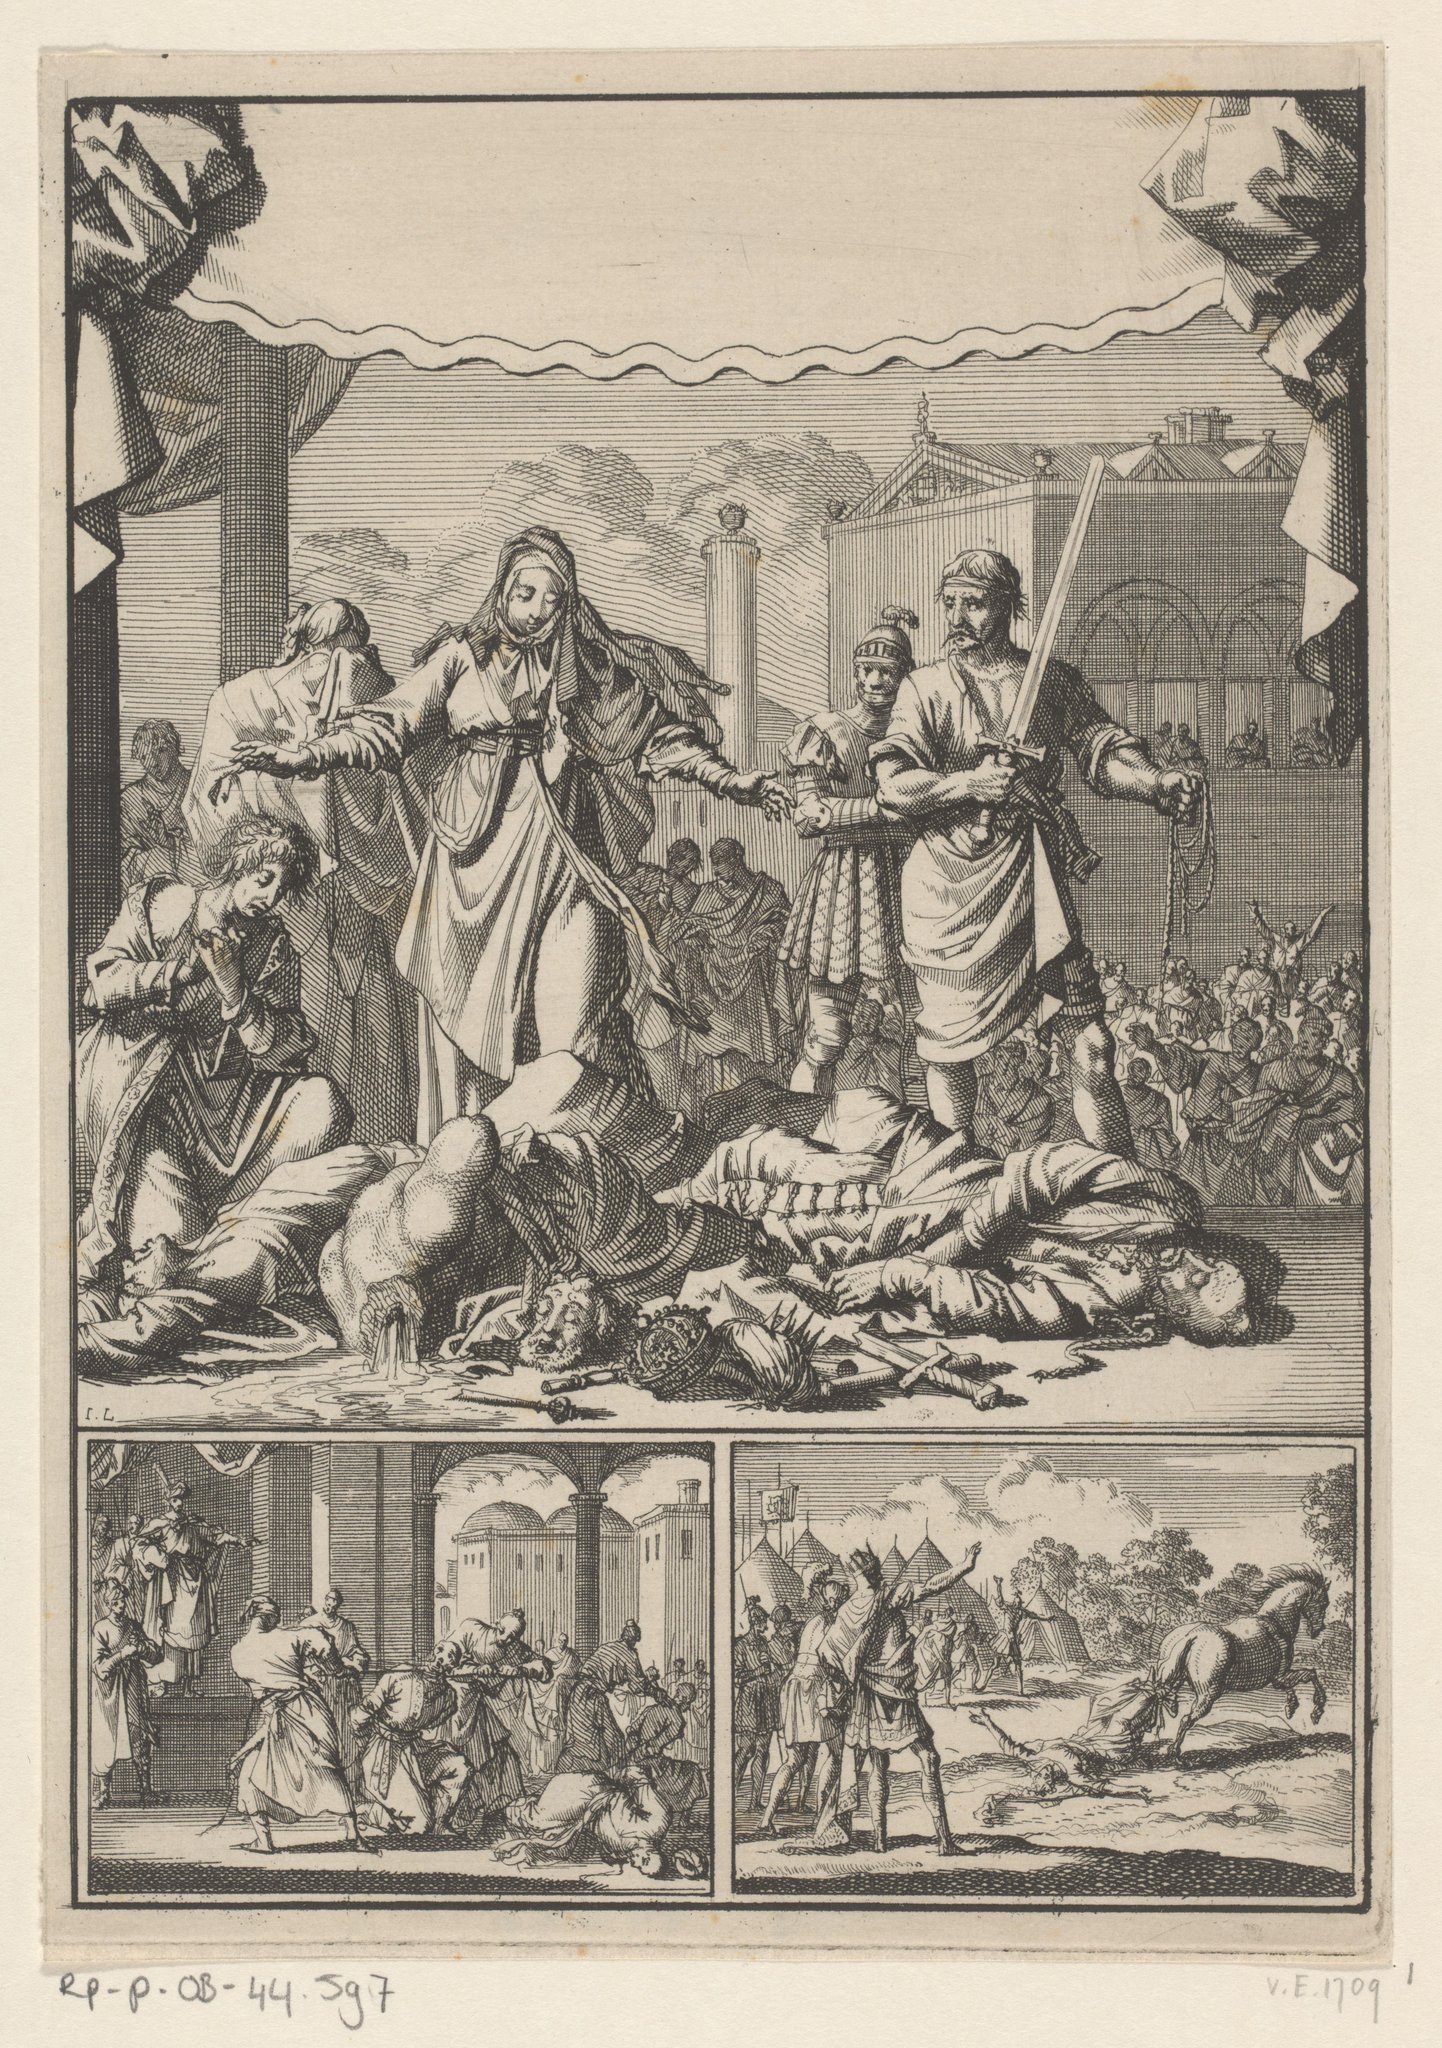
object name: print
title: Trouw, Barmhartigheid en Liefde aanschouwen drie ter dood gebrachte figuren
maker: jan luyken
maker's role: draughtsman, print maker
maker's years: 1649-1712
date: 1698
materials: paper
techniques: etching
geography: amsterdam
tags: friendliness, gentleness, affability; 'affabilità, piacevolezza, amabilità', 'animo piacevole, trattabile & amorevole', 'benignità' (ripa), fidelity; 'fedeltà' (ripa), death penalty, execution, mercy, compassion; 'compassione', 'misericordia' (ripa)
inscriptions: collector's mark: Lugt 2228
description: De personificaties van Trouw, Barmhartigheid en Liefde aanschouwen vol medelijden een gewurgde Turk, een onthoofde vorst en een derde ter dood gebracht figuur. Rechts de beul met zwaard en wurgkoord. Onder deze hoofdvoorstelling twee kleine scènes waarin figuren op wrede wijze van hun leven worden beroofd.